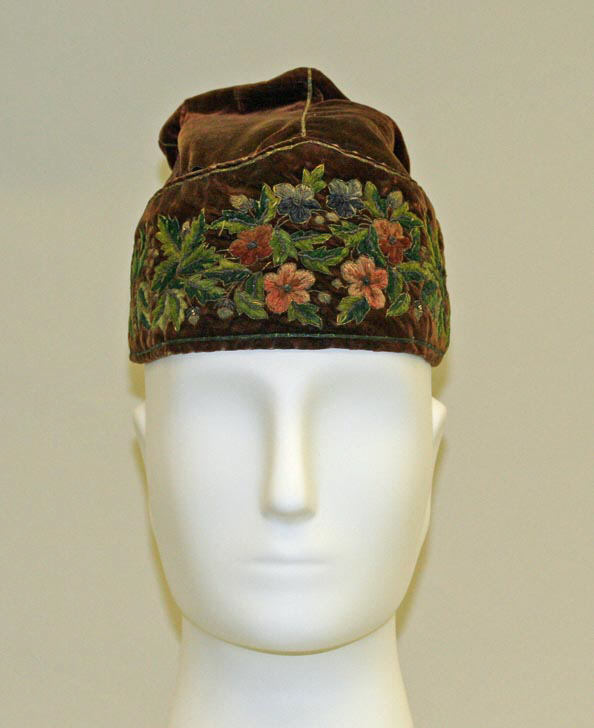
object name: cap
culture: polish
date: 1870-1880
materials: metal thread, silk